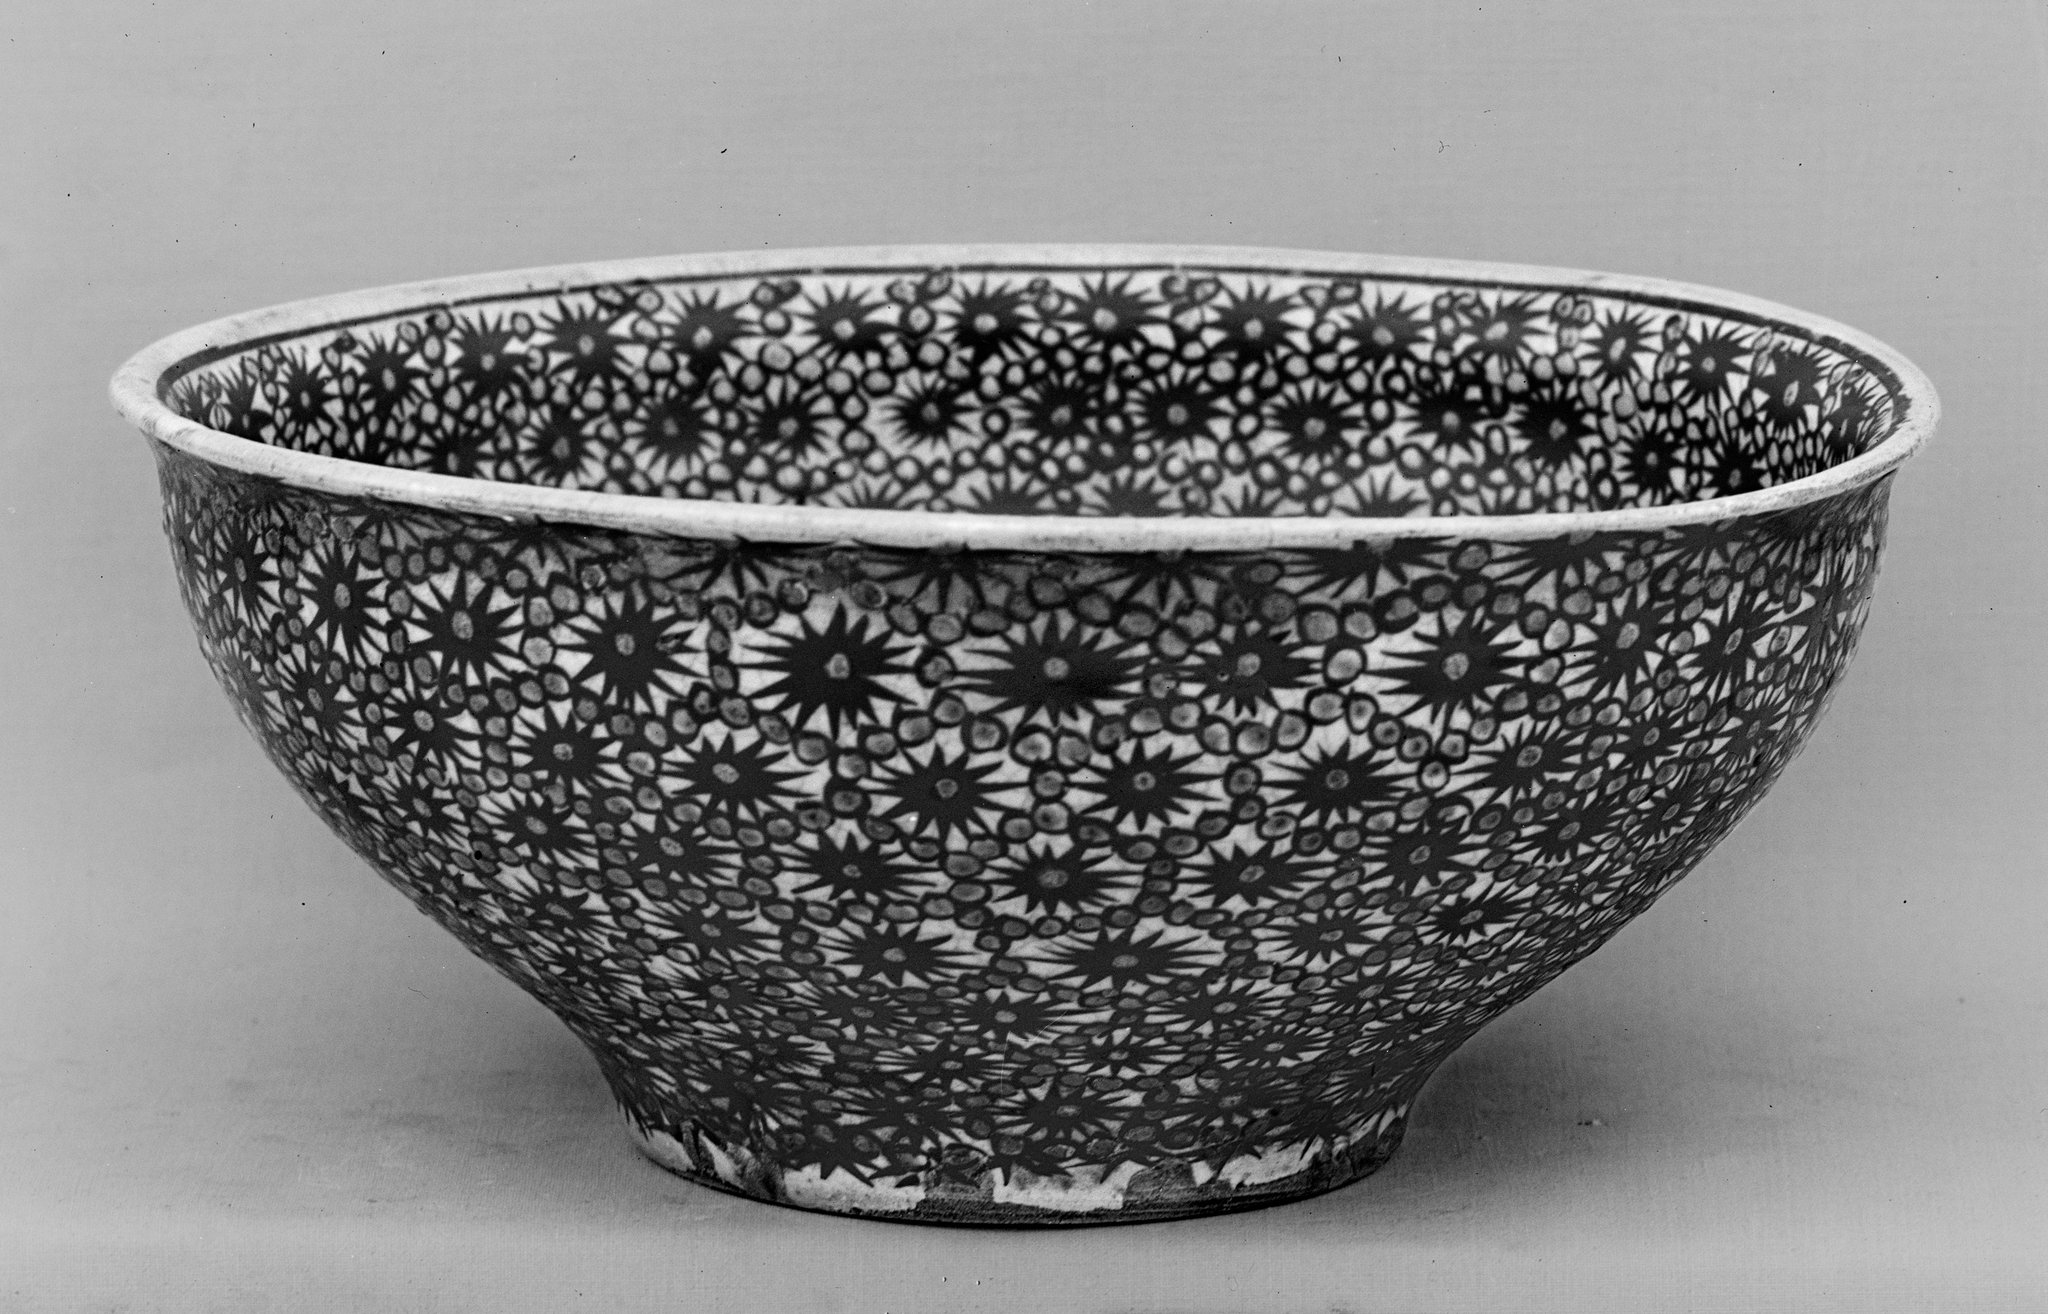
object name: bowl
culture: japanese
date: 1701-1800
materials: clay, enamel, glaze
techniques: polychrome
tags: flowers